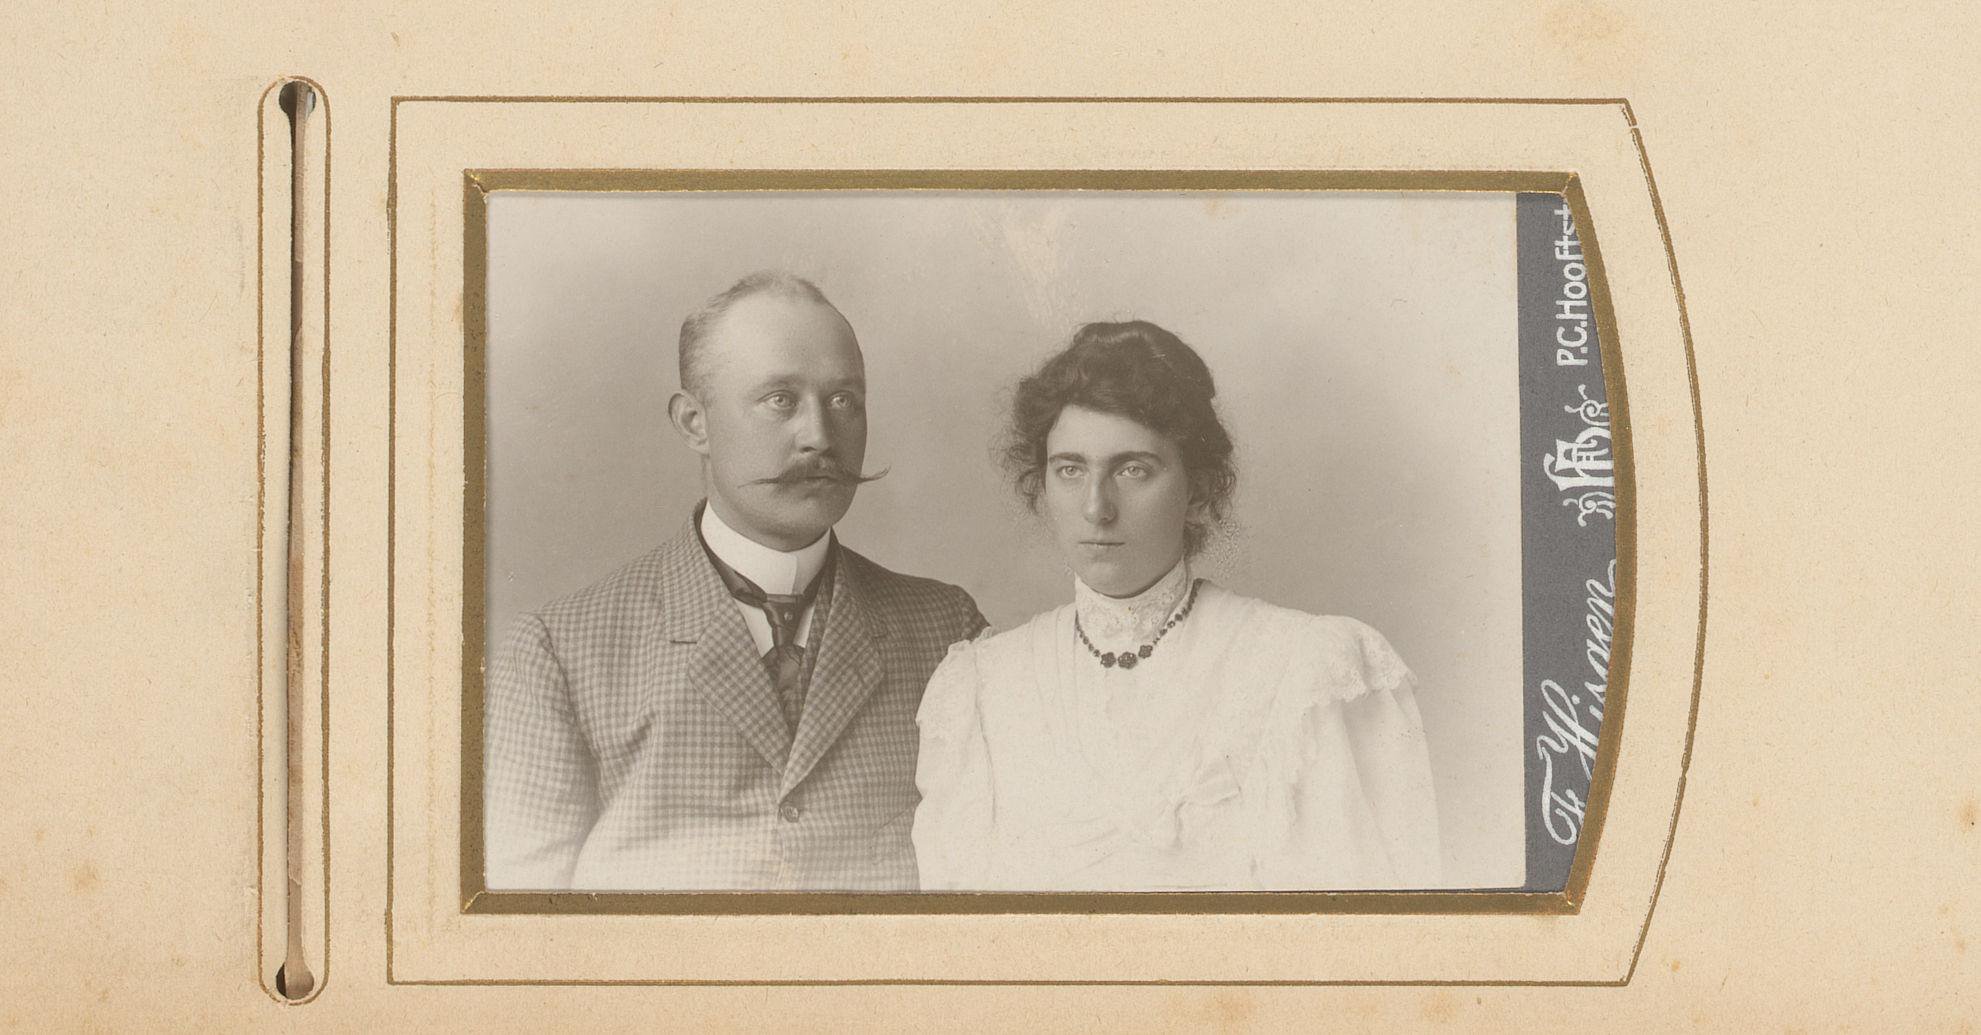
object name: album leaf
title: Portret van een man met snor en een vrouw met opgestoken haar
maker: friedrich carel hisgen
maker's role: fotograaf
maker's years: 1846-1912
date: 1891-1912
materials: cardboard, photographic support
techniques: collodion silver print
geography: amsterdam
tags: historical persons - bb - woman, moustache, historical persons, hairdress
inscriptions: inscription: ‘F. Hisgen/ P.C.Hooftstraat 72/ Atelier Parterre.’